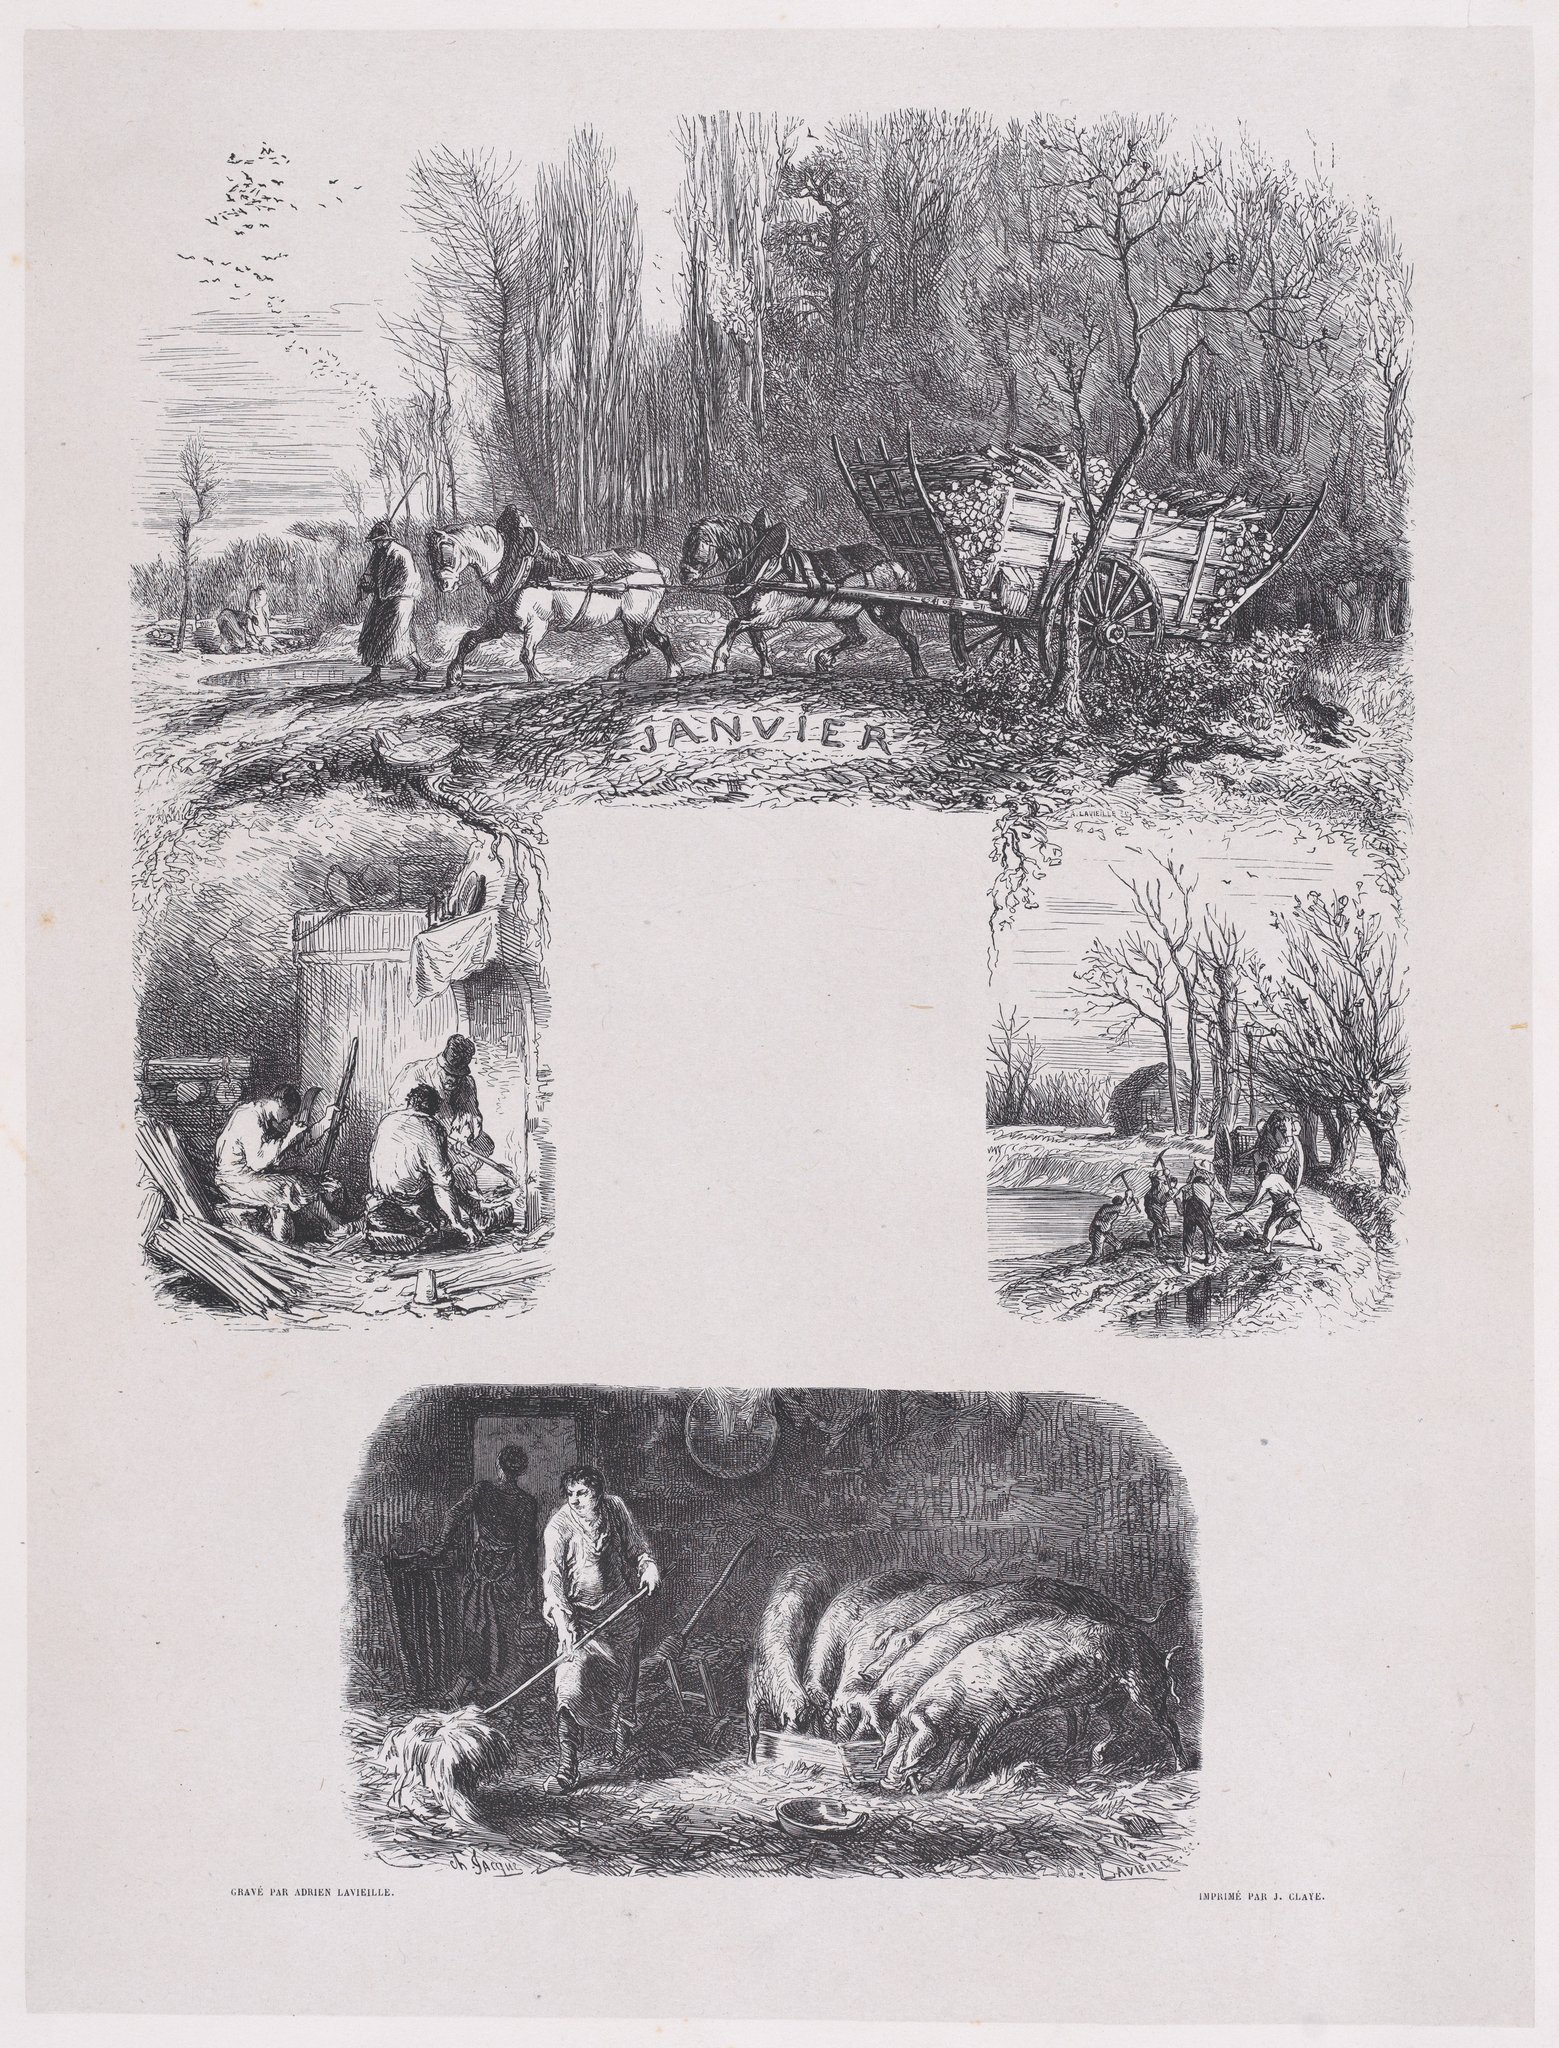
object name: print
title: January, from "Album of Rustic Subjects"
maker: charles émile jacque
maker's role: artist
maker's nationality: french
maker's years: 1813-1894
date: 1859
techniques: engraving